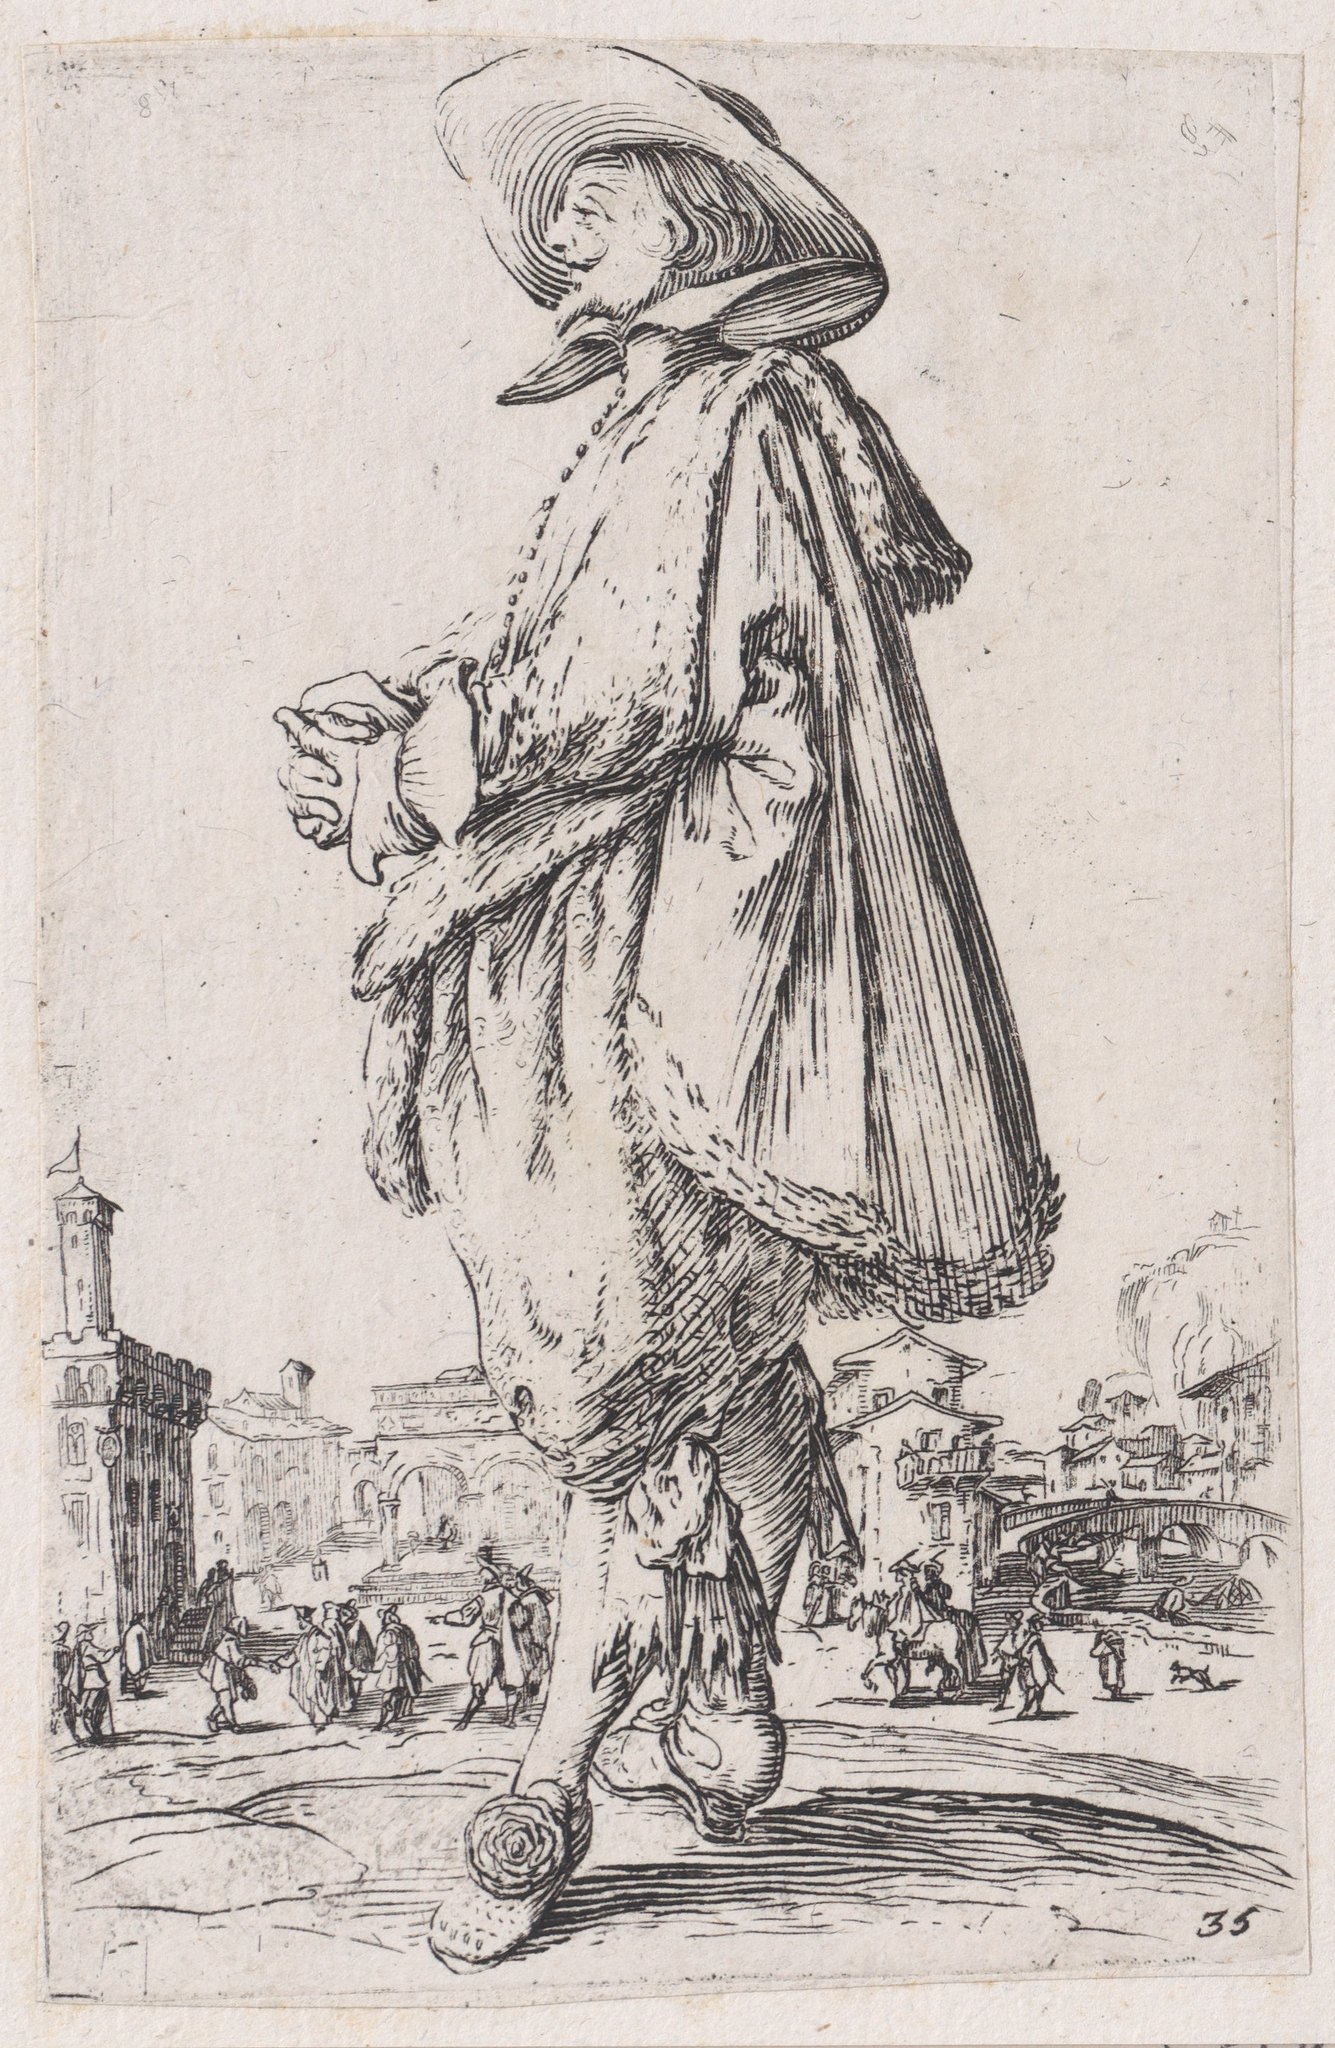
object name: print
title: Reverse Copy of Le Mendiant a la Jambe de Bois (The Beggar with the Wooden Leg), from Les Gueux suite appelée aussi Les Mendiants, Les Baroni, ou Les Barons (The Beggars, also called the Barons)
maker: Anonymous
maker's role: artist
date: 1601-1700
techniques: etching